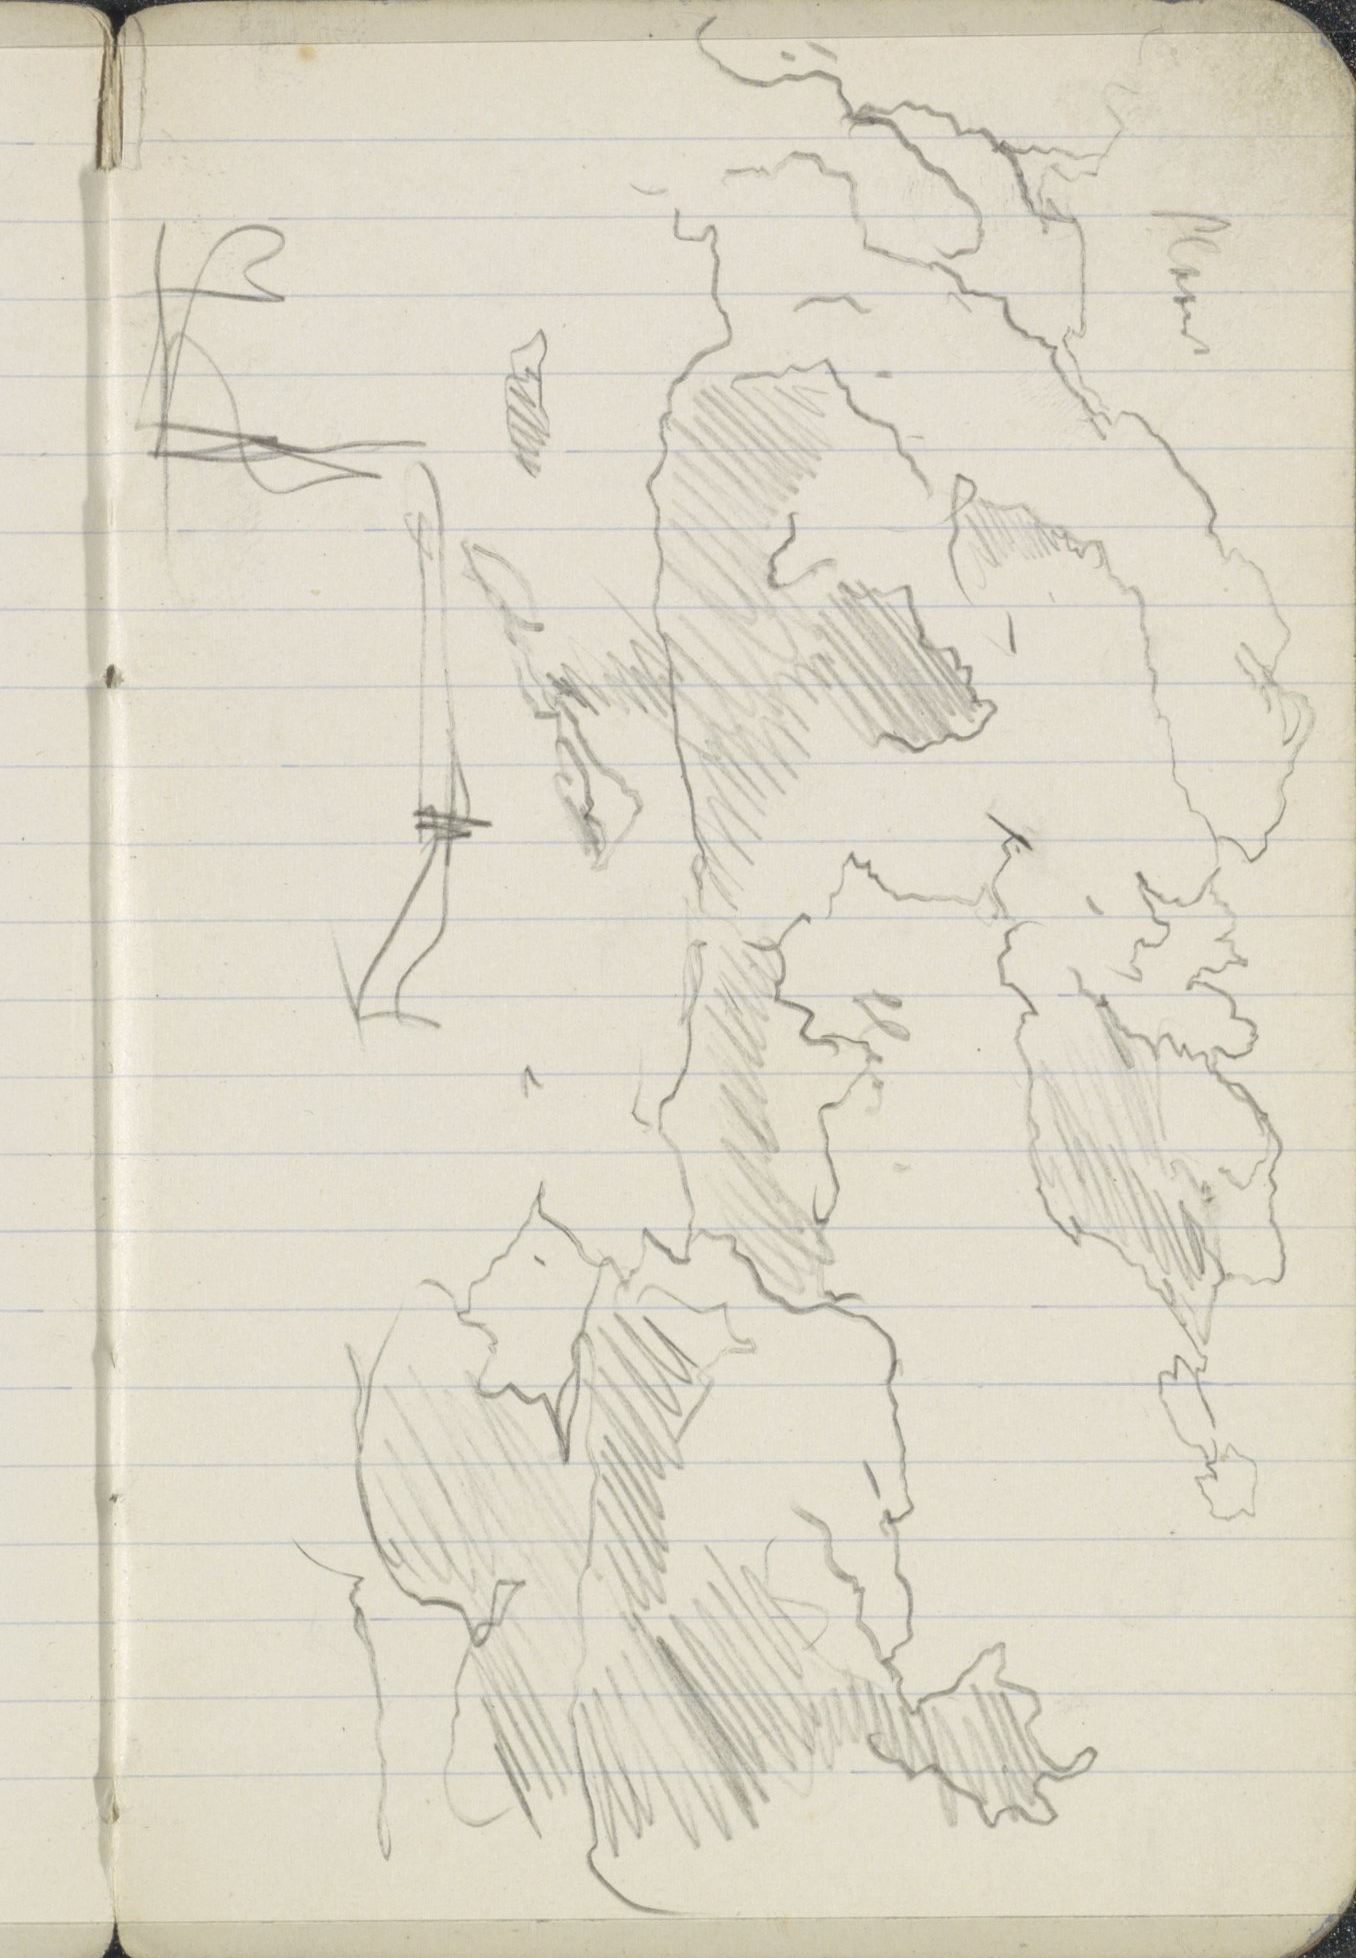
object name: sketchbook leaf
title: Wolkenlucht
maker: george hendrik breitner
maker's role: draughtsman, painter, print maker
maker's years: 1857-1923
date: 1896-1897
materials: chalk, pencil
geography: amsterdam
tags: clouds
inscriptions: kleurnotitie, handgeschreven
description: Pagina 58 uit een schetsboek met 39 bladen.